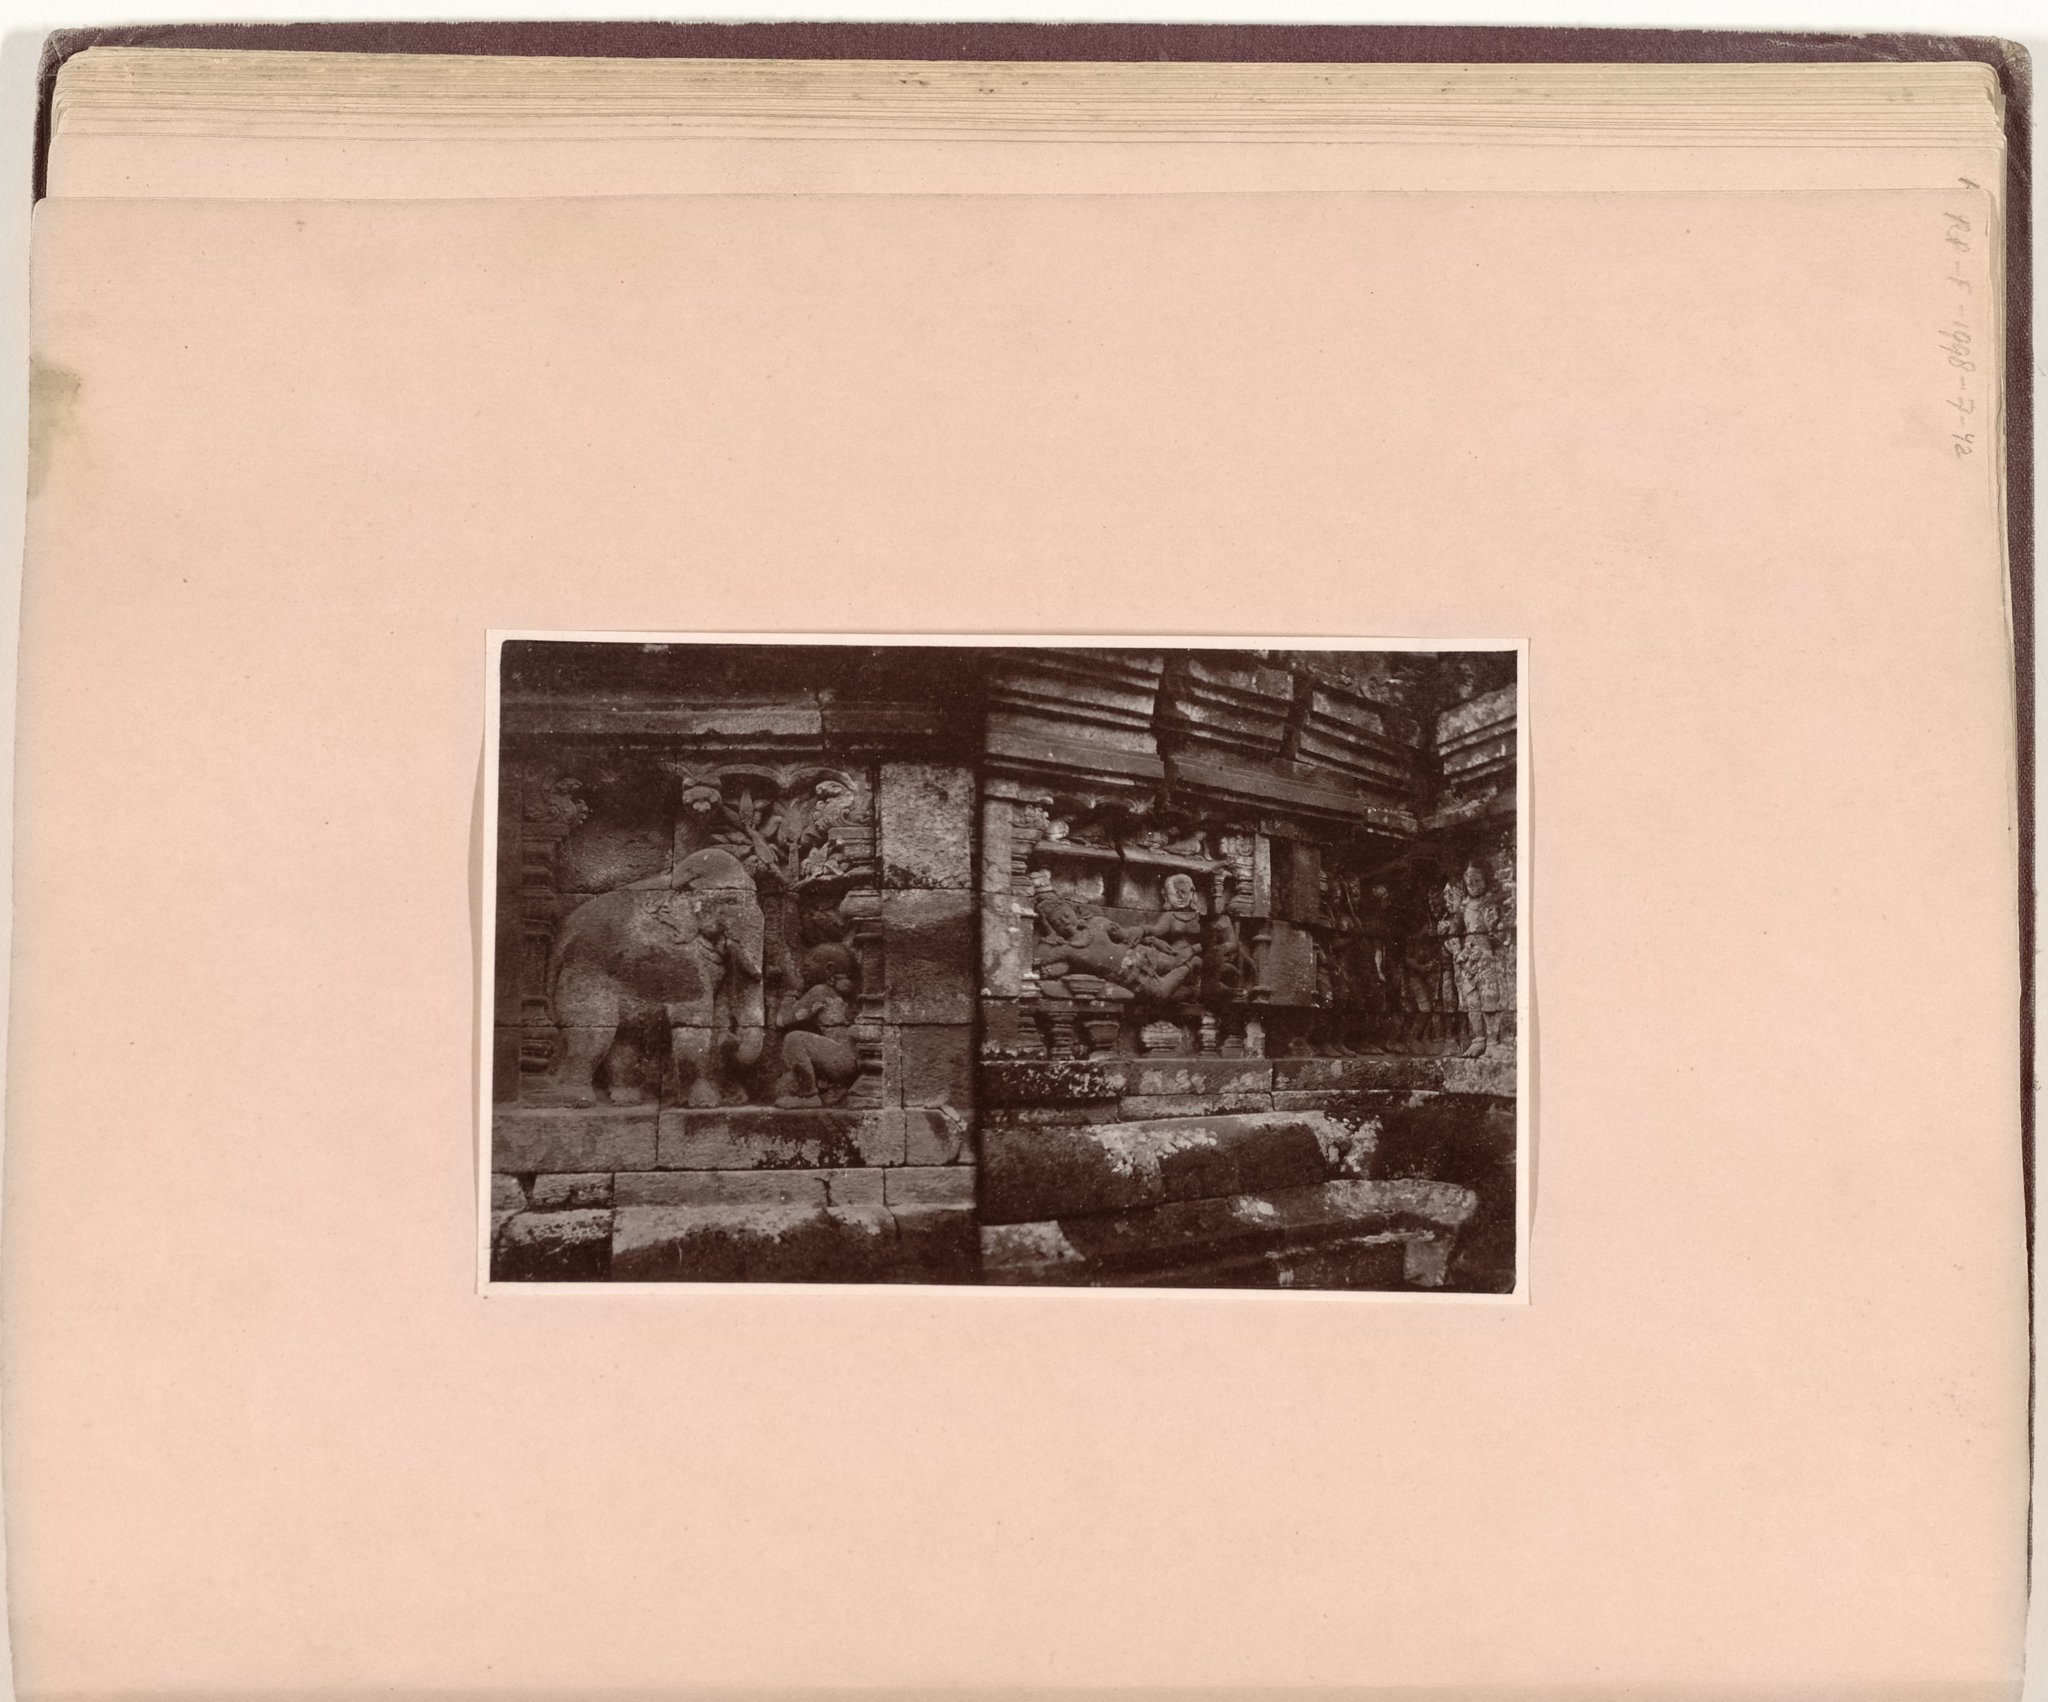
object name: photograph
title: Reliëfs van de Borobudur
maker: c. dietrich (fotograaf)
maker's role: fotograaf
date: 1875-1890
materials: cardboard, paper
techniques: albumen print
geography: java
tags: sculpture (+ relief ~ sculpture)